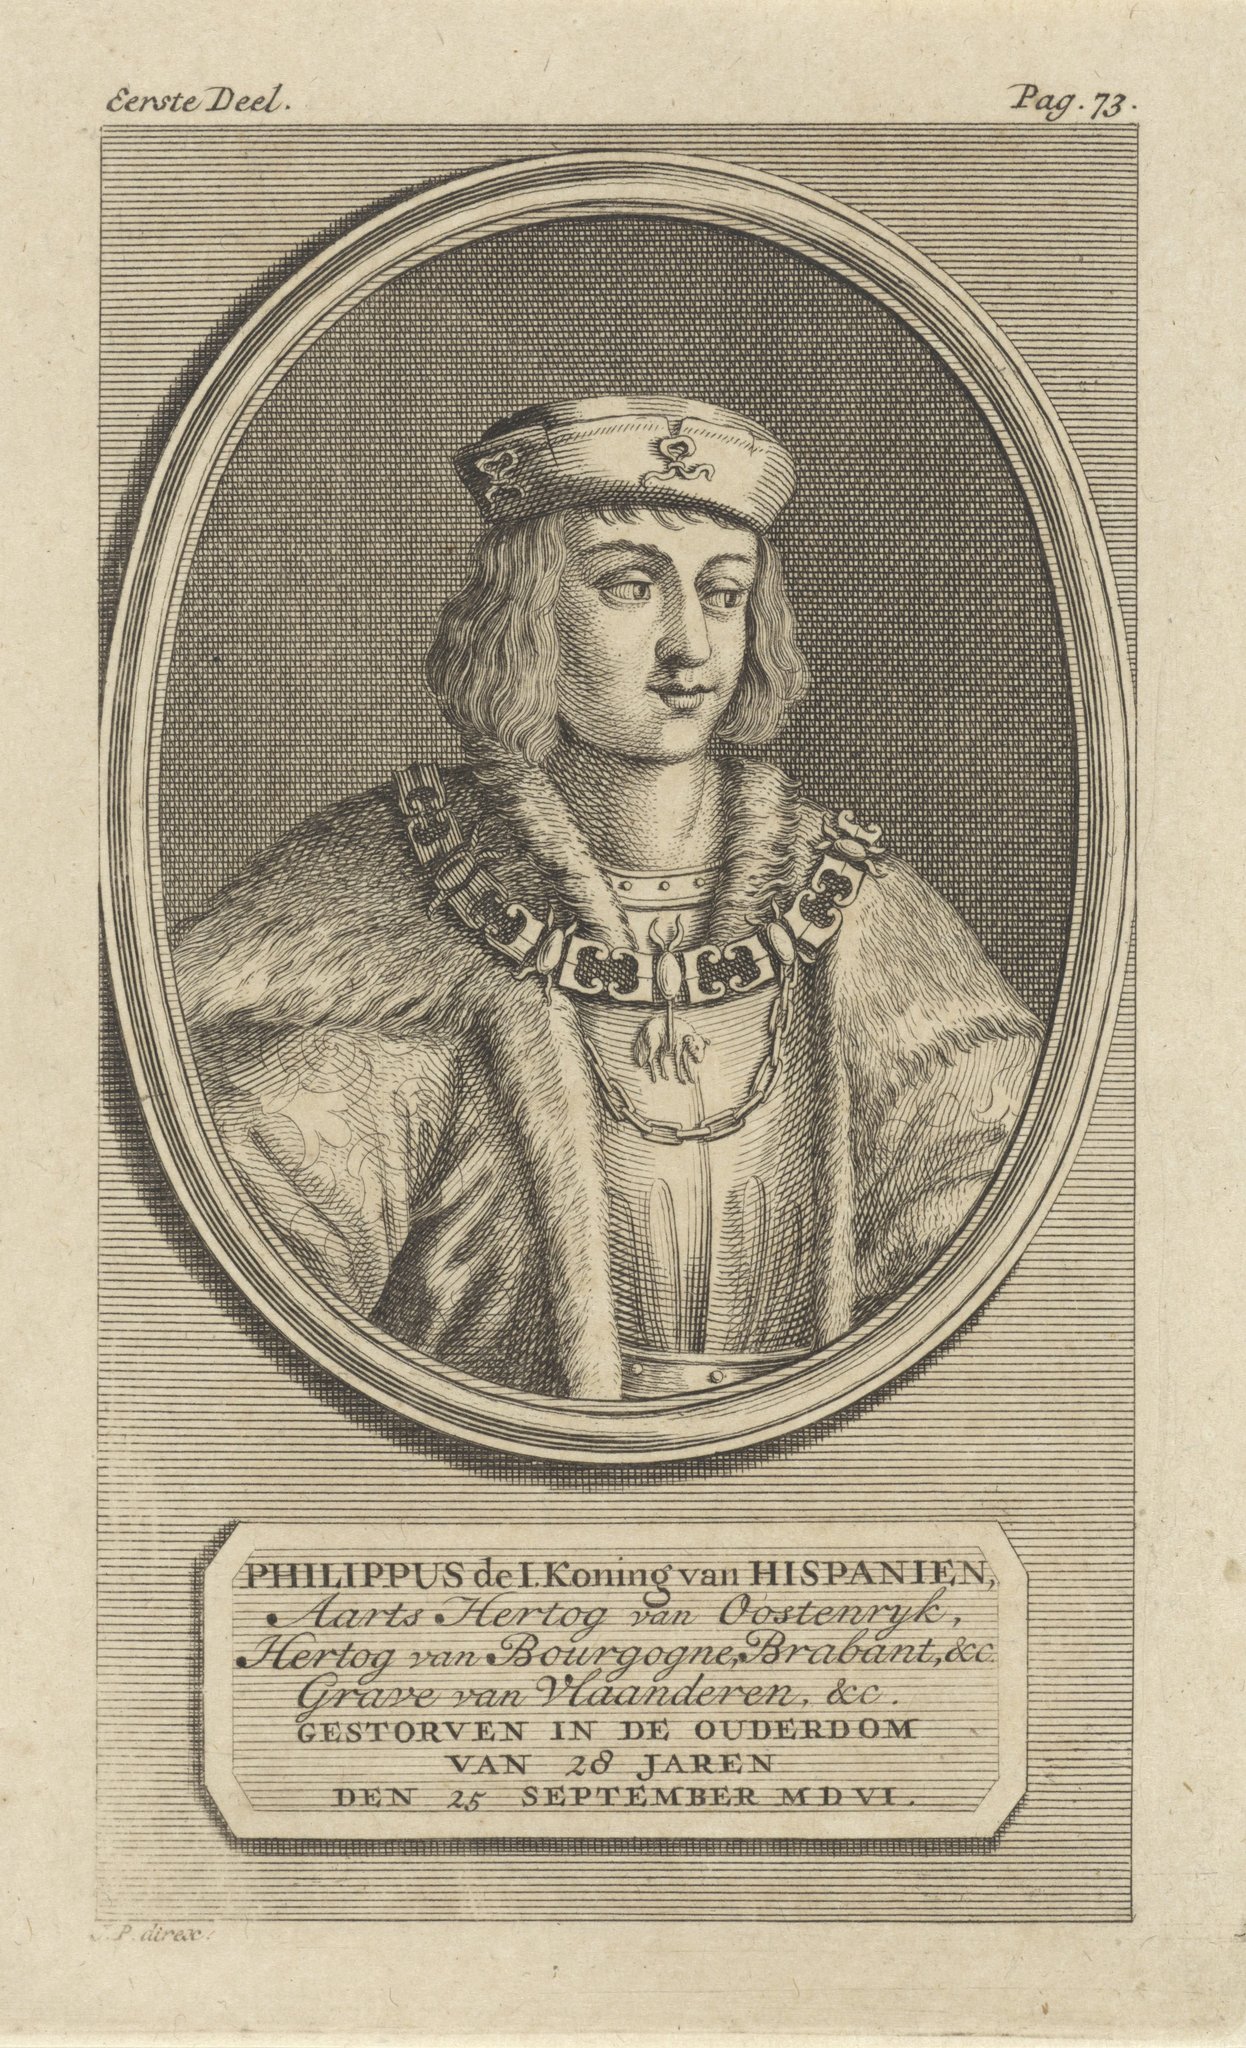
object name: print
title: Portret van Filips de Schone, hertog van Bourgondië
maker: jan punt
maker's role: draughtsman, print maker, publisher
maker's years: 1711-1779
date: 1748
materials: paper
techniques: engraving, etching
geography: northern netherlands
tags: bruges, filips de schone (hertog van bourgondië), knighthood order of the golden fleece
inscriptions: collector's mark: Lugt 2228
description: Illustratie uit: Meteren, Emanuel van. Historie van de oorlogen en geschiedenissen der Nederlanderen, en der zelver naburen: beginnende met den jare 1315, en eindigende met den jare 1611, deel I, p. 73. Gorinchem/Breda: Nicolaas Goetzee, Pieter Goetzee/Willem Goetzee, 1748.